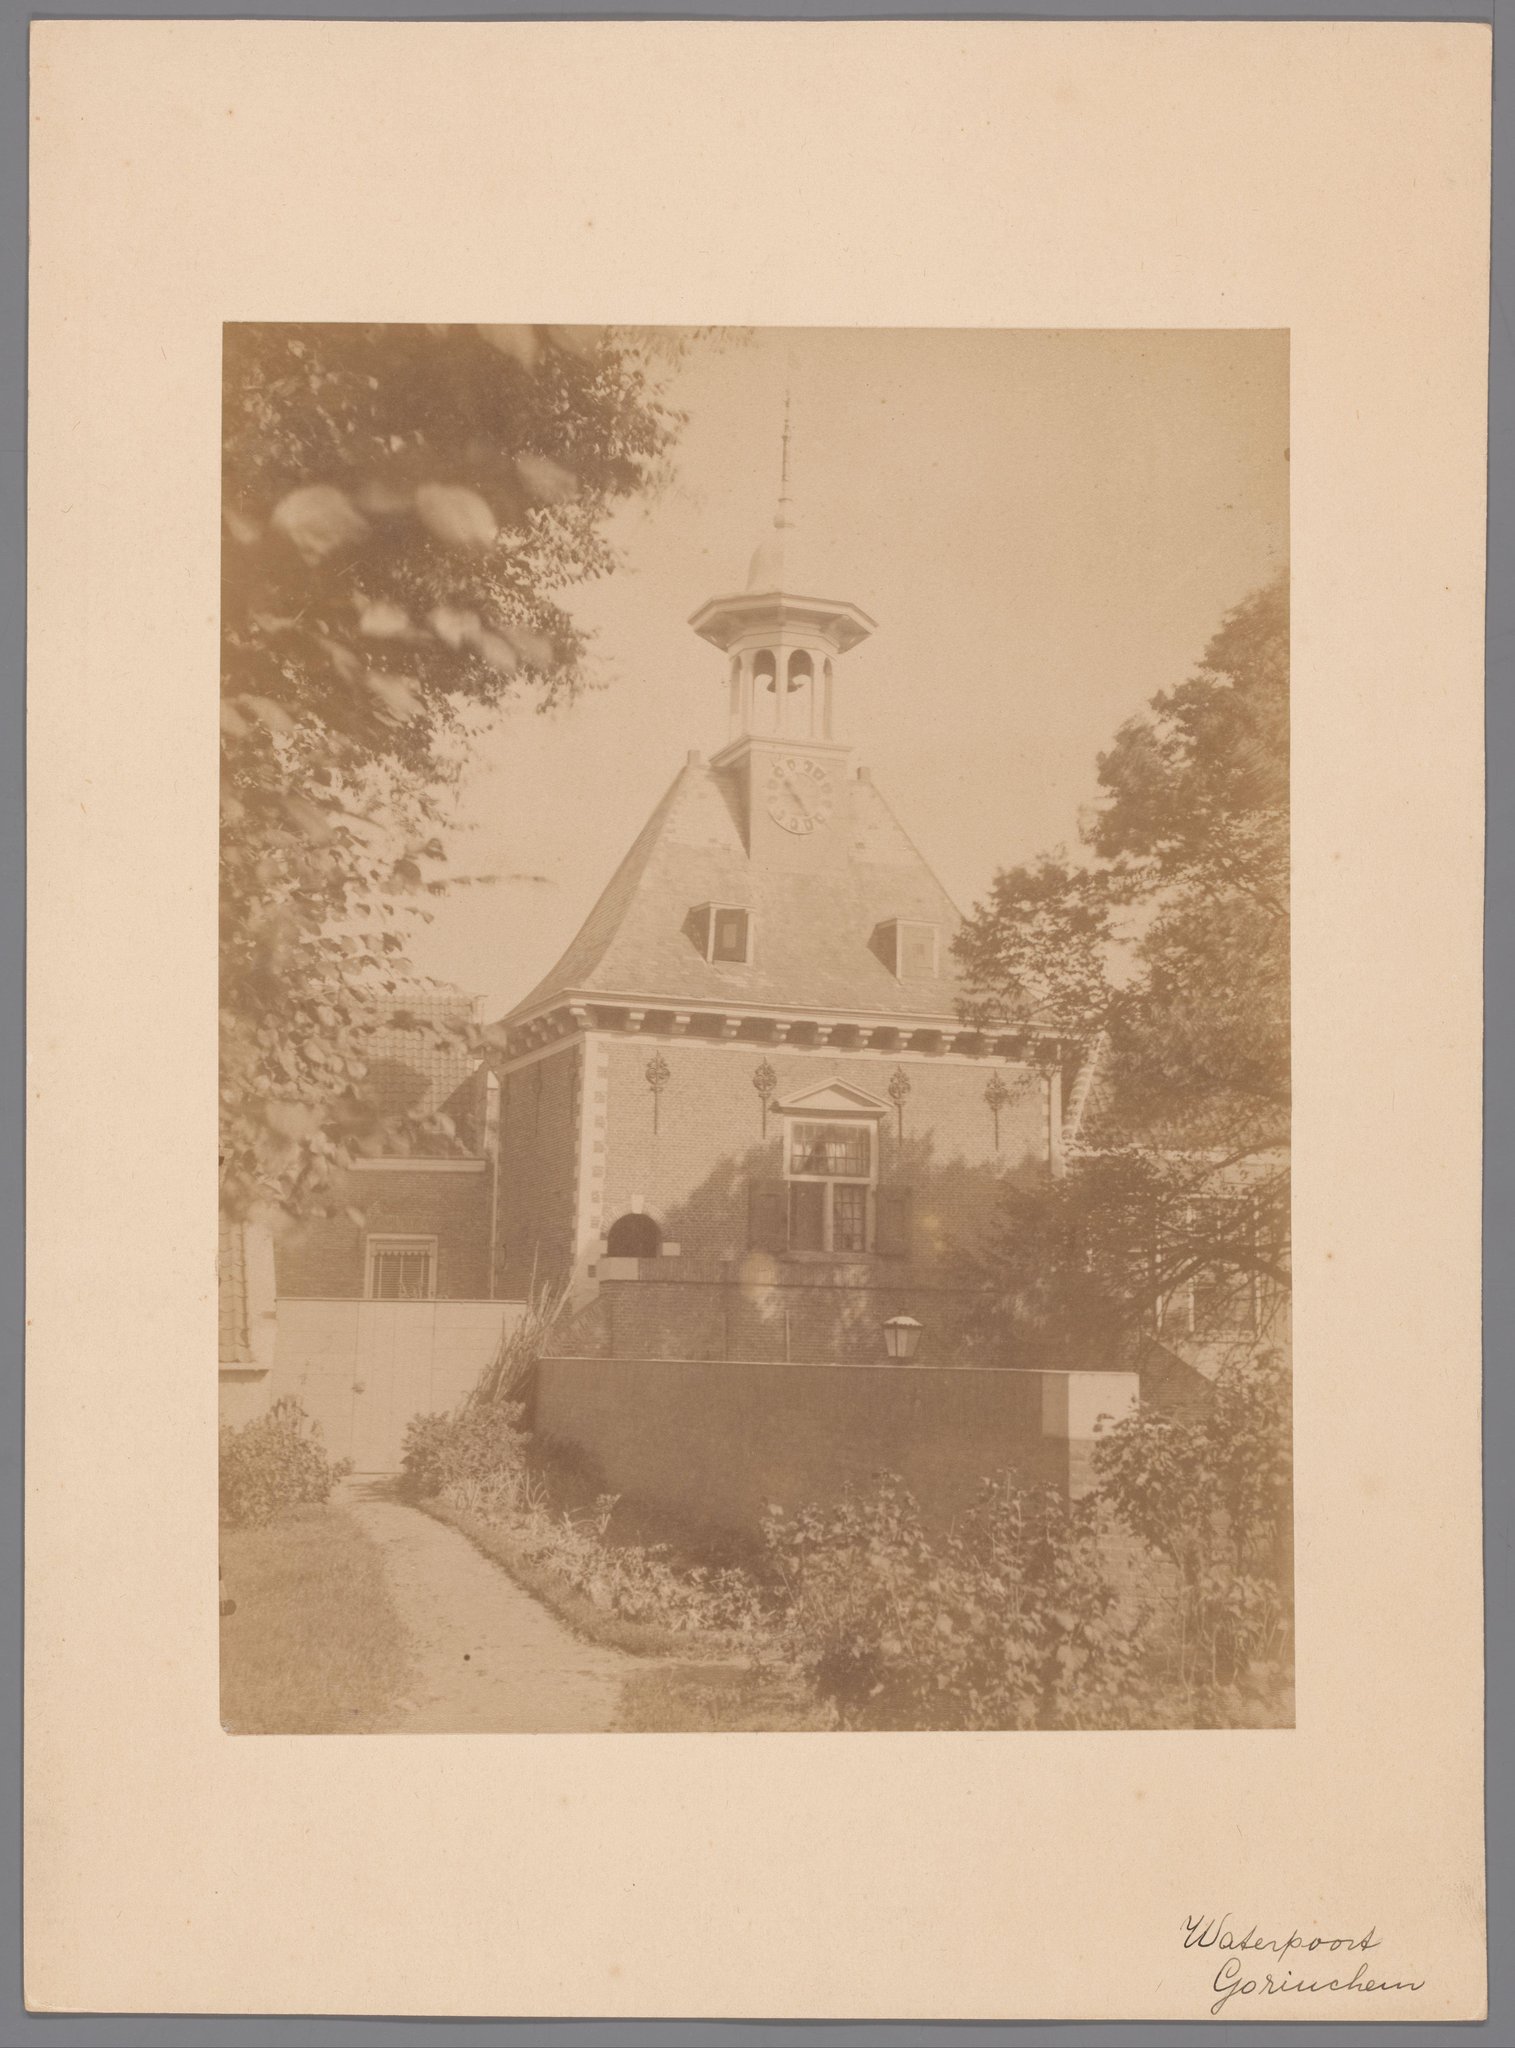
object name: photograph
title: Gezicht op de waterpoort te Gorinchem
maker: anoniem (monumentenzorg)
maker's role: fotograaf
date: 1890-1915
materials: cardboard, photographic support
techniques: albumen print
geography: gorinchem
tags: watergate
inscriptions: annotation: ‘Gorinchem Waterpoort’, annotation: ‘Waterpoort/ Gorinchem’